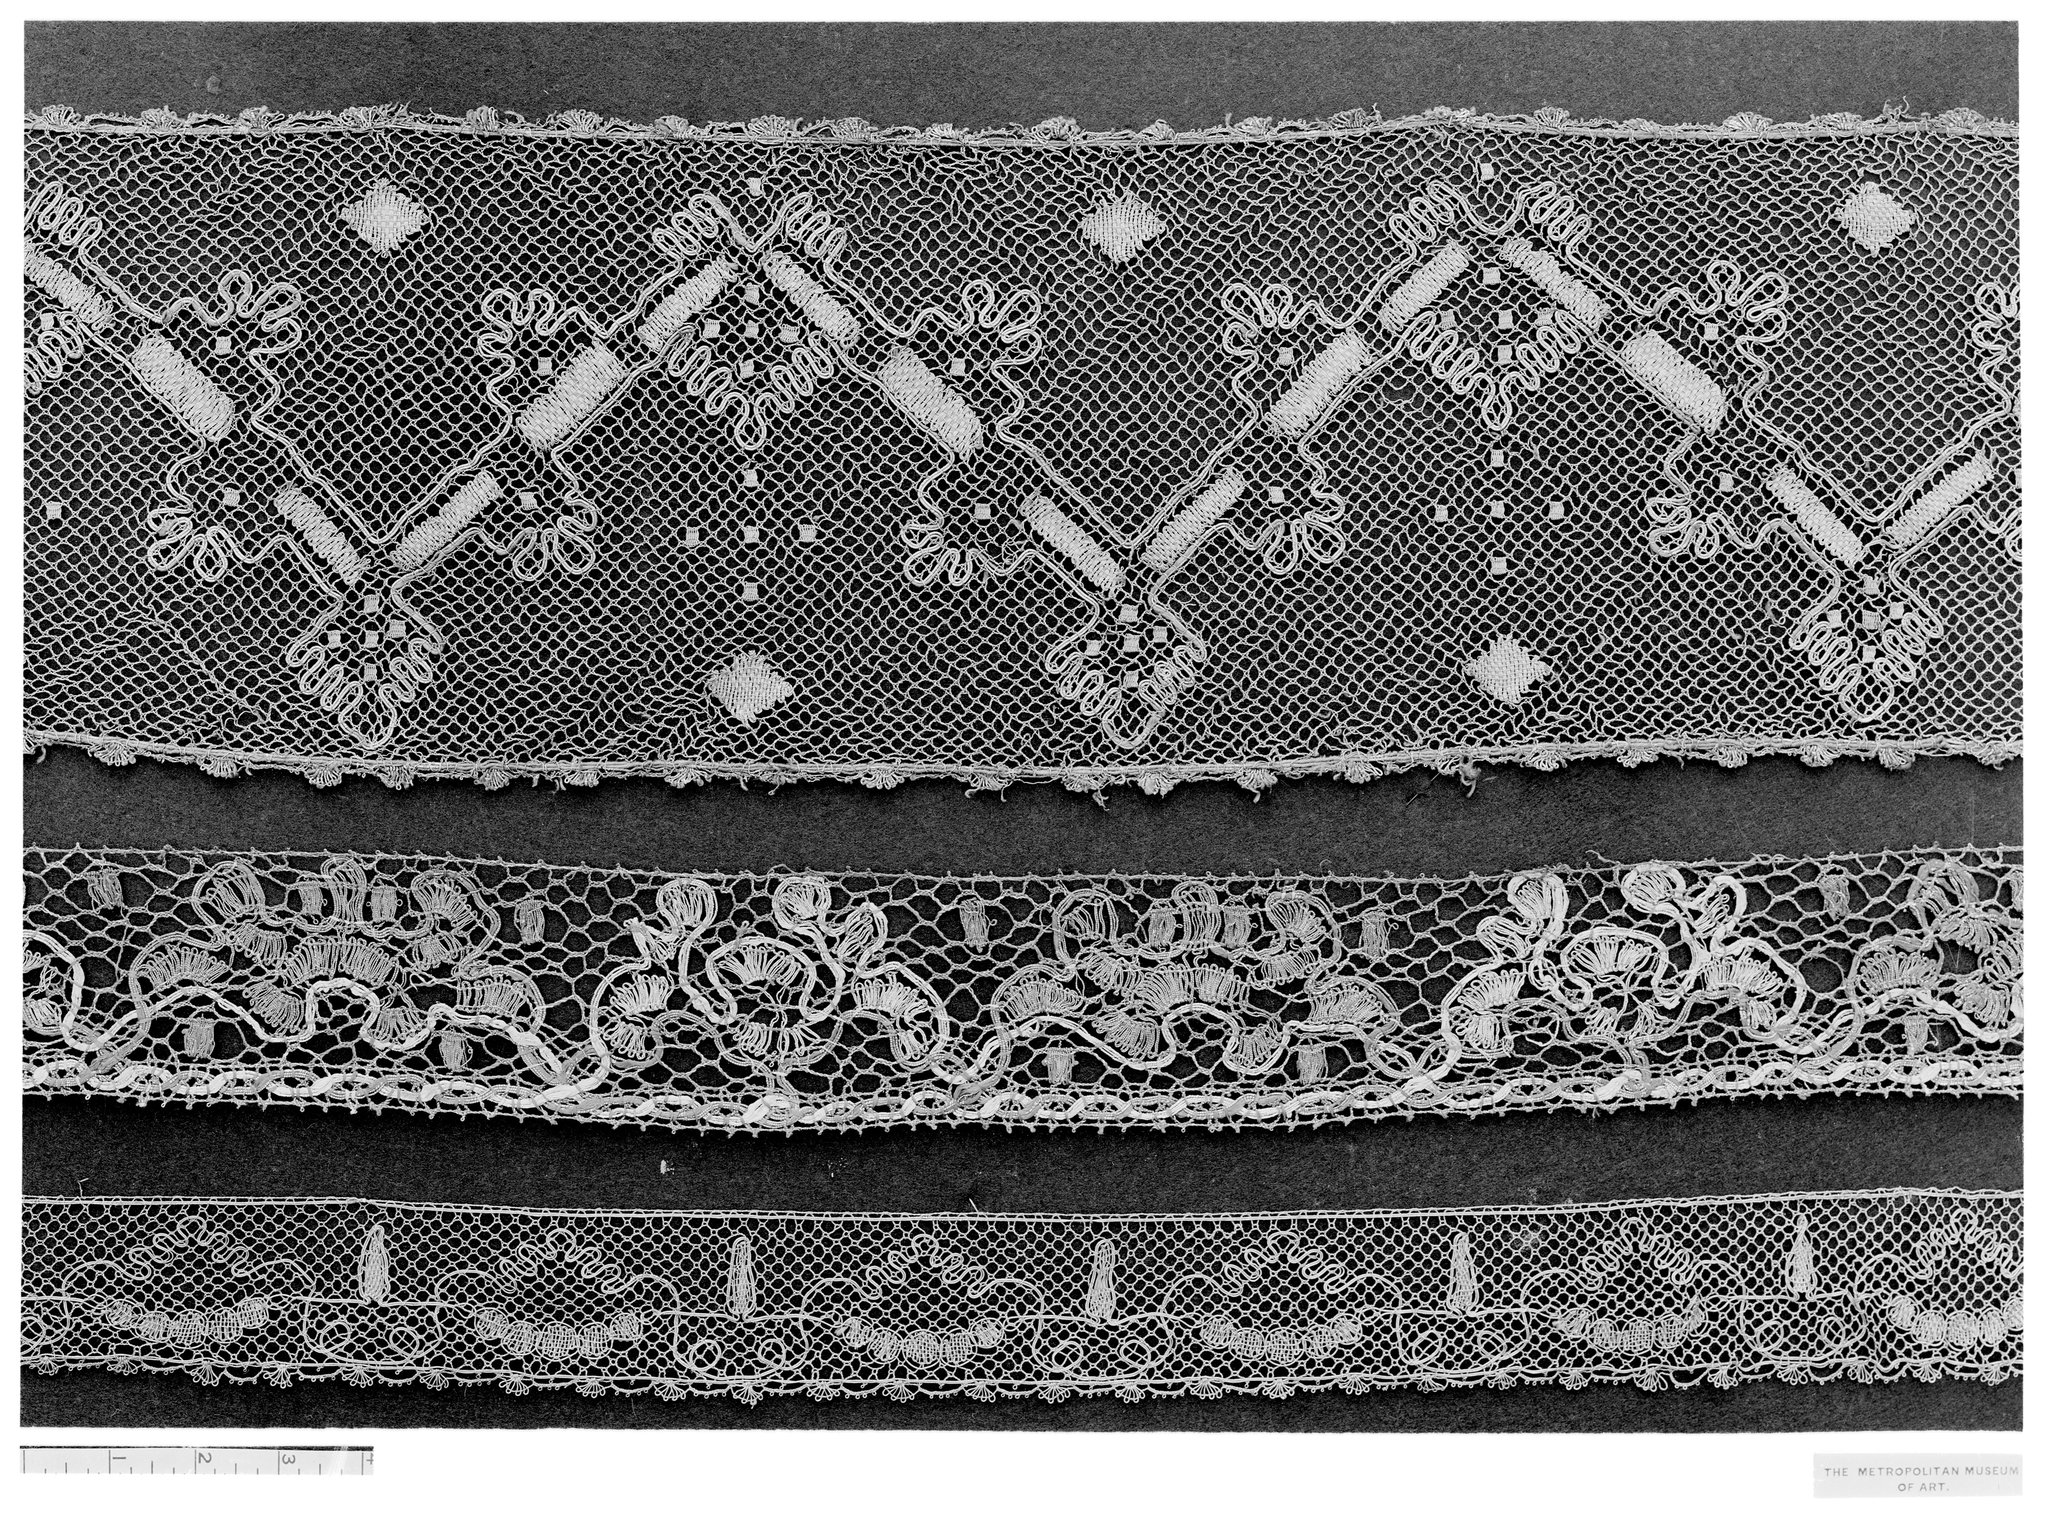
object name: fragment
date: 1501-1600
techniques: lace